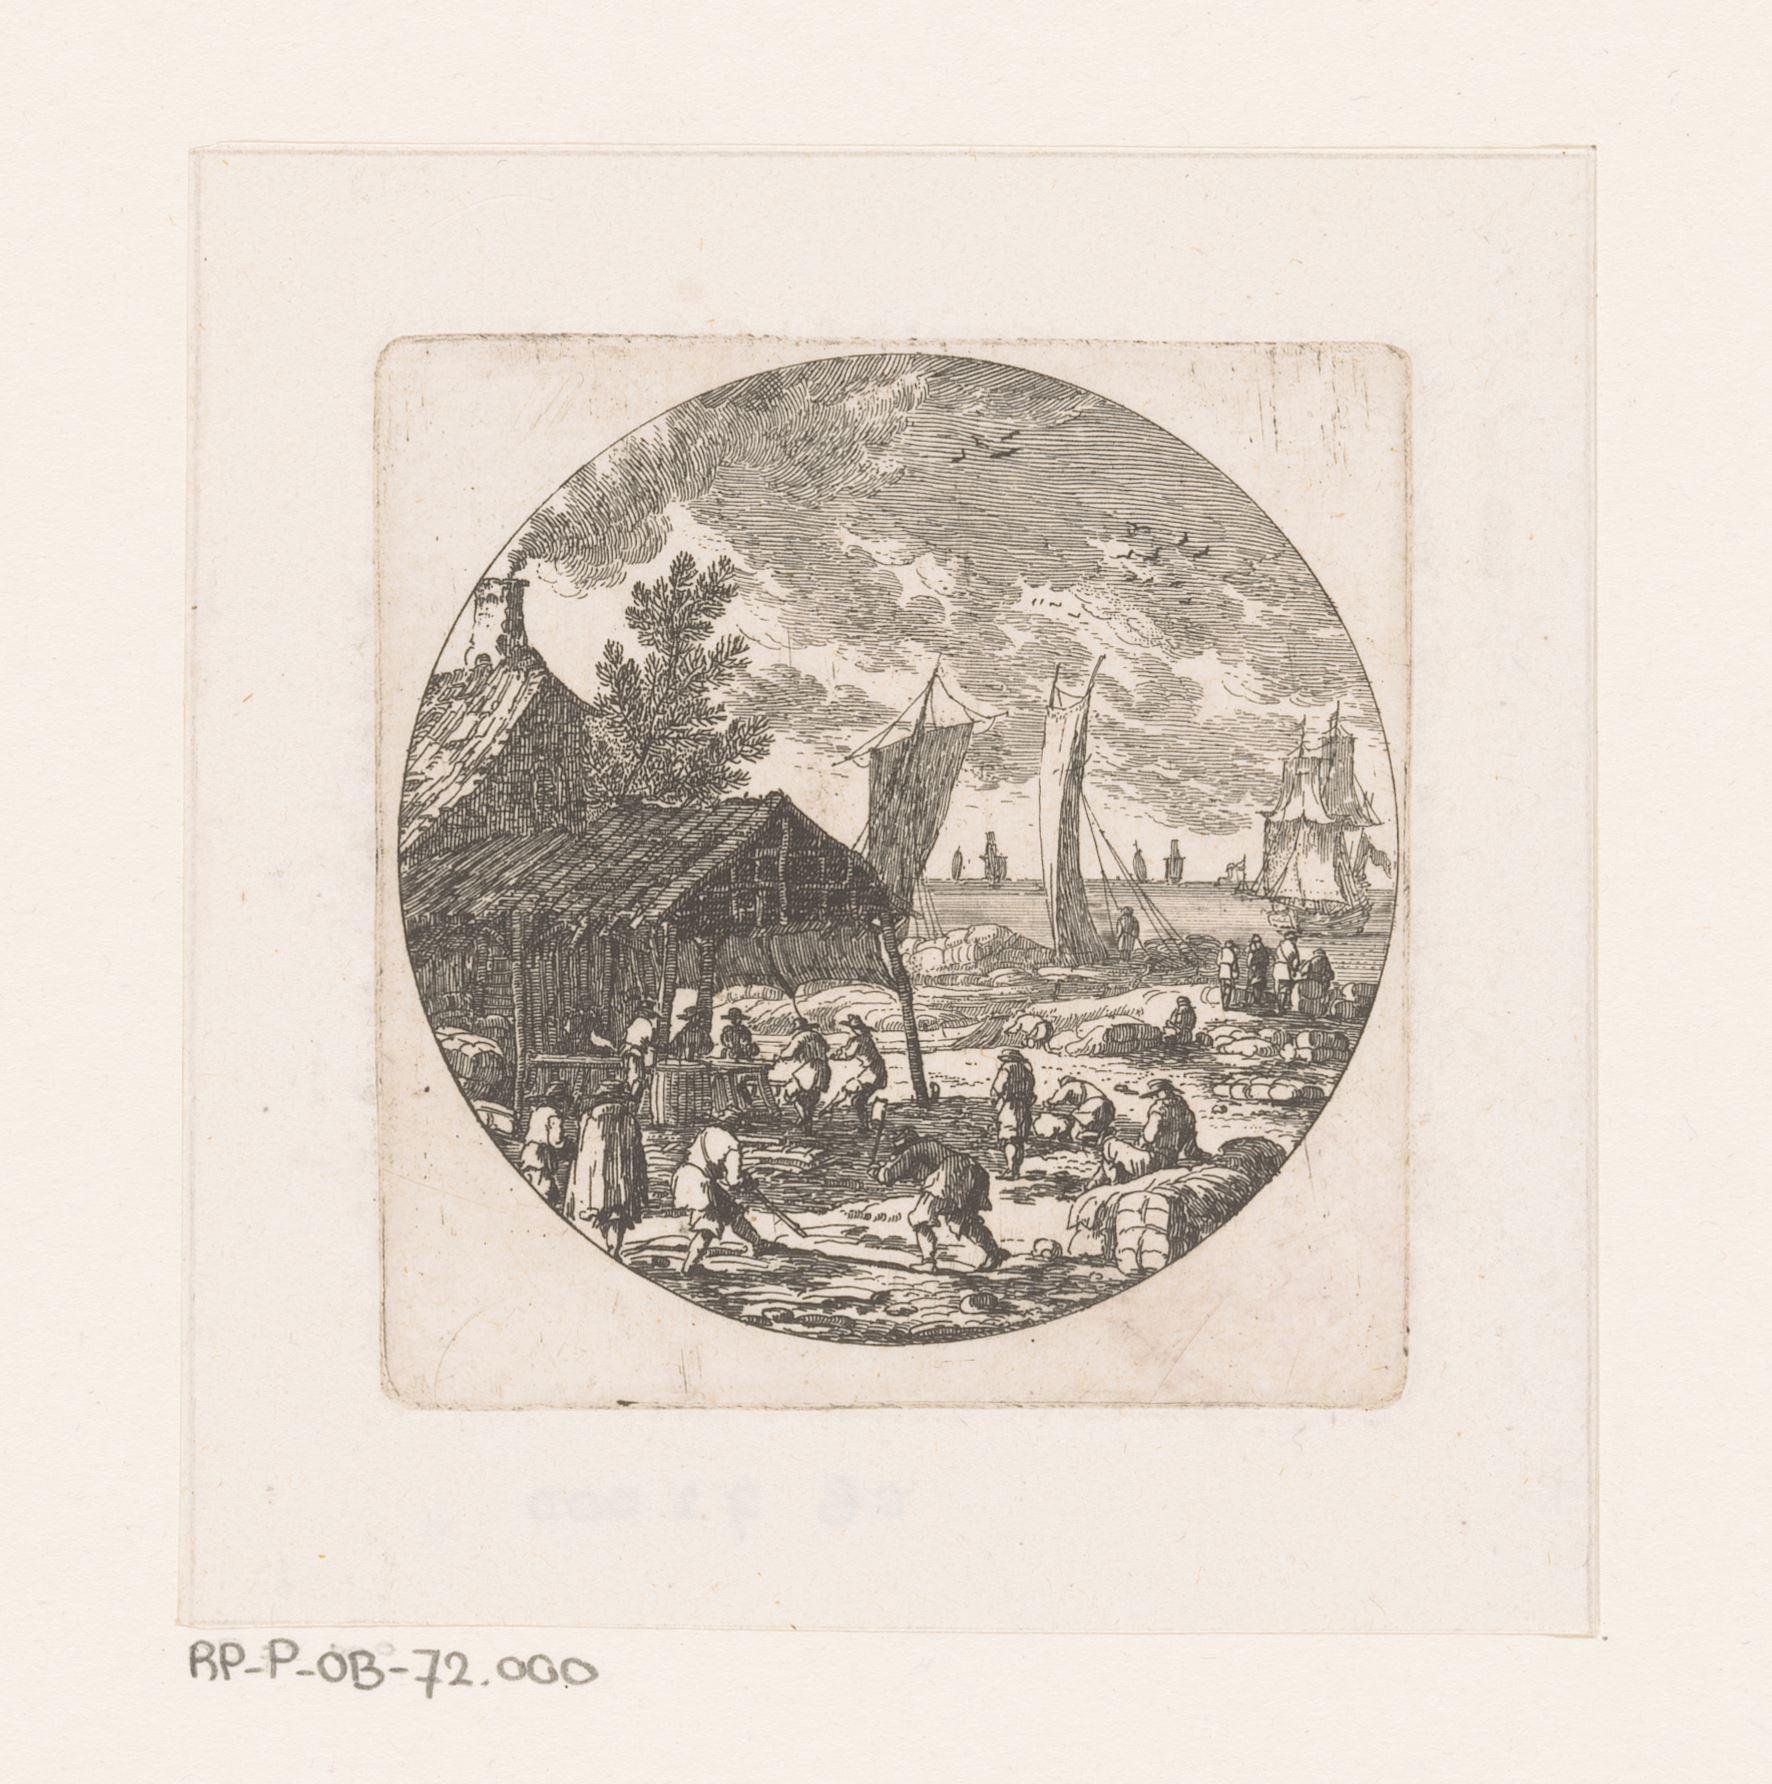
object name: print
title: Bedrijvigheid op kade aan zee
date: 1613-1695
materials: paper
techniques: etching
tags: harbour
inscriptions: collector's mark: Lugt 240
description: Prenten met het signatuur 'Perelle' kunnen zowel door vader Gabriel als door zonen Nicolas en Adam gemaakt zijn.